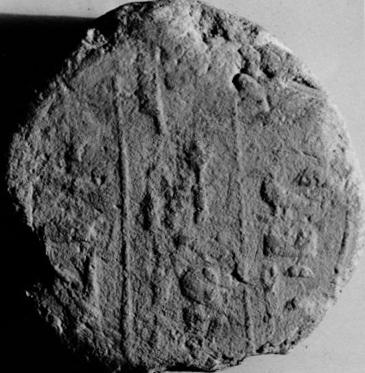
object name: cone, senenre, servant, amun, scribe, satmenhetet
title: Funerary Cone of Senenre and His Wife Satmenhetet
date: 1479-1425 BCE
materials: pottery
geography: egypt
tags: hieroglyphs